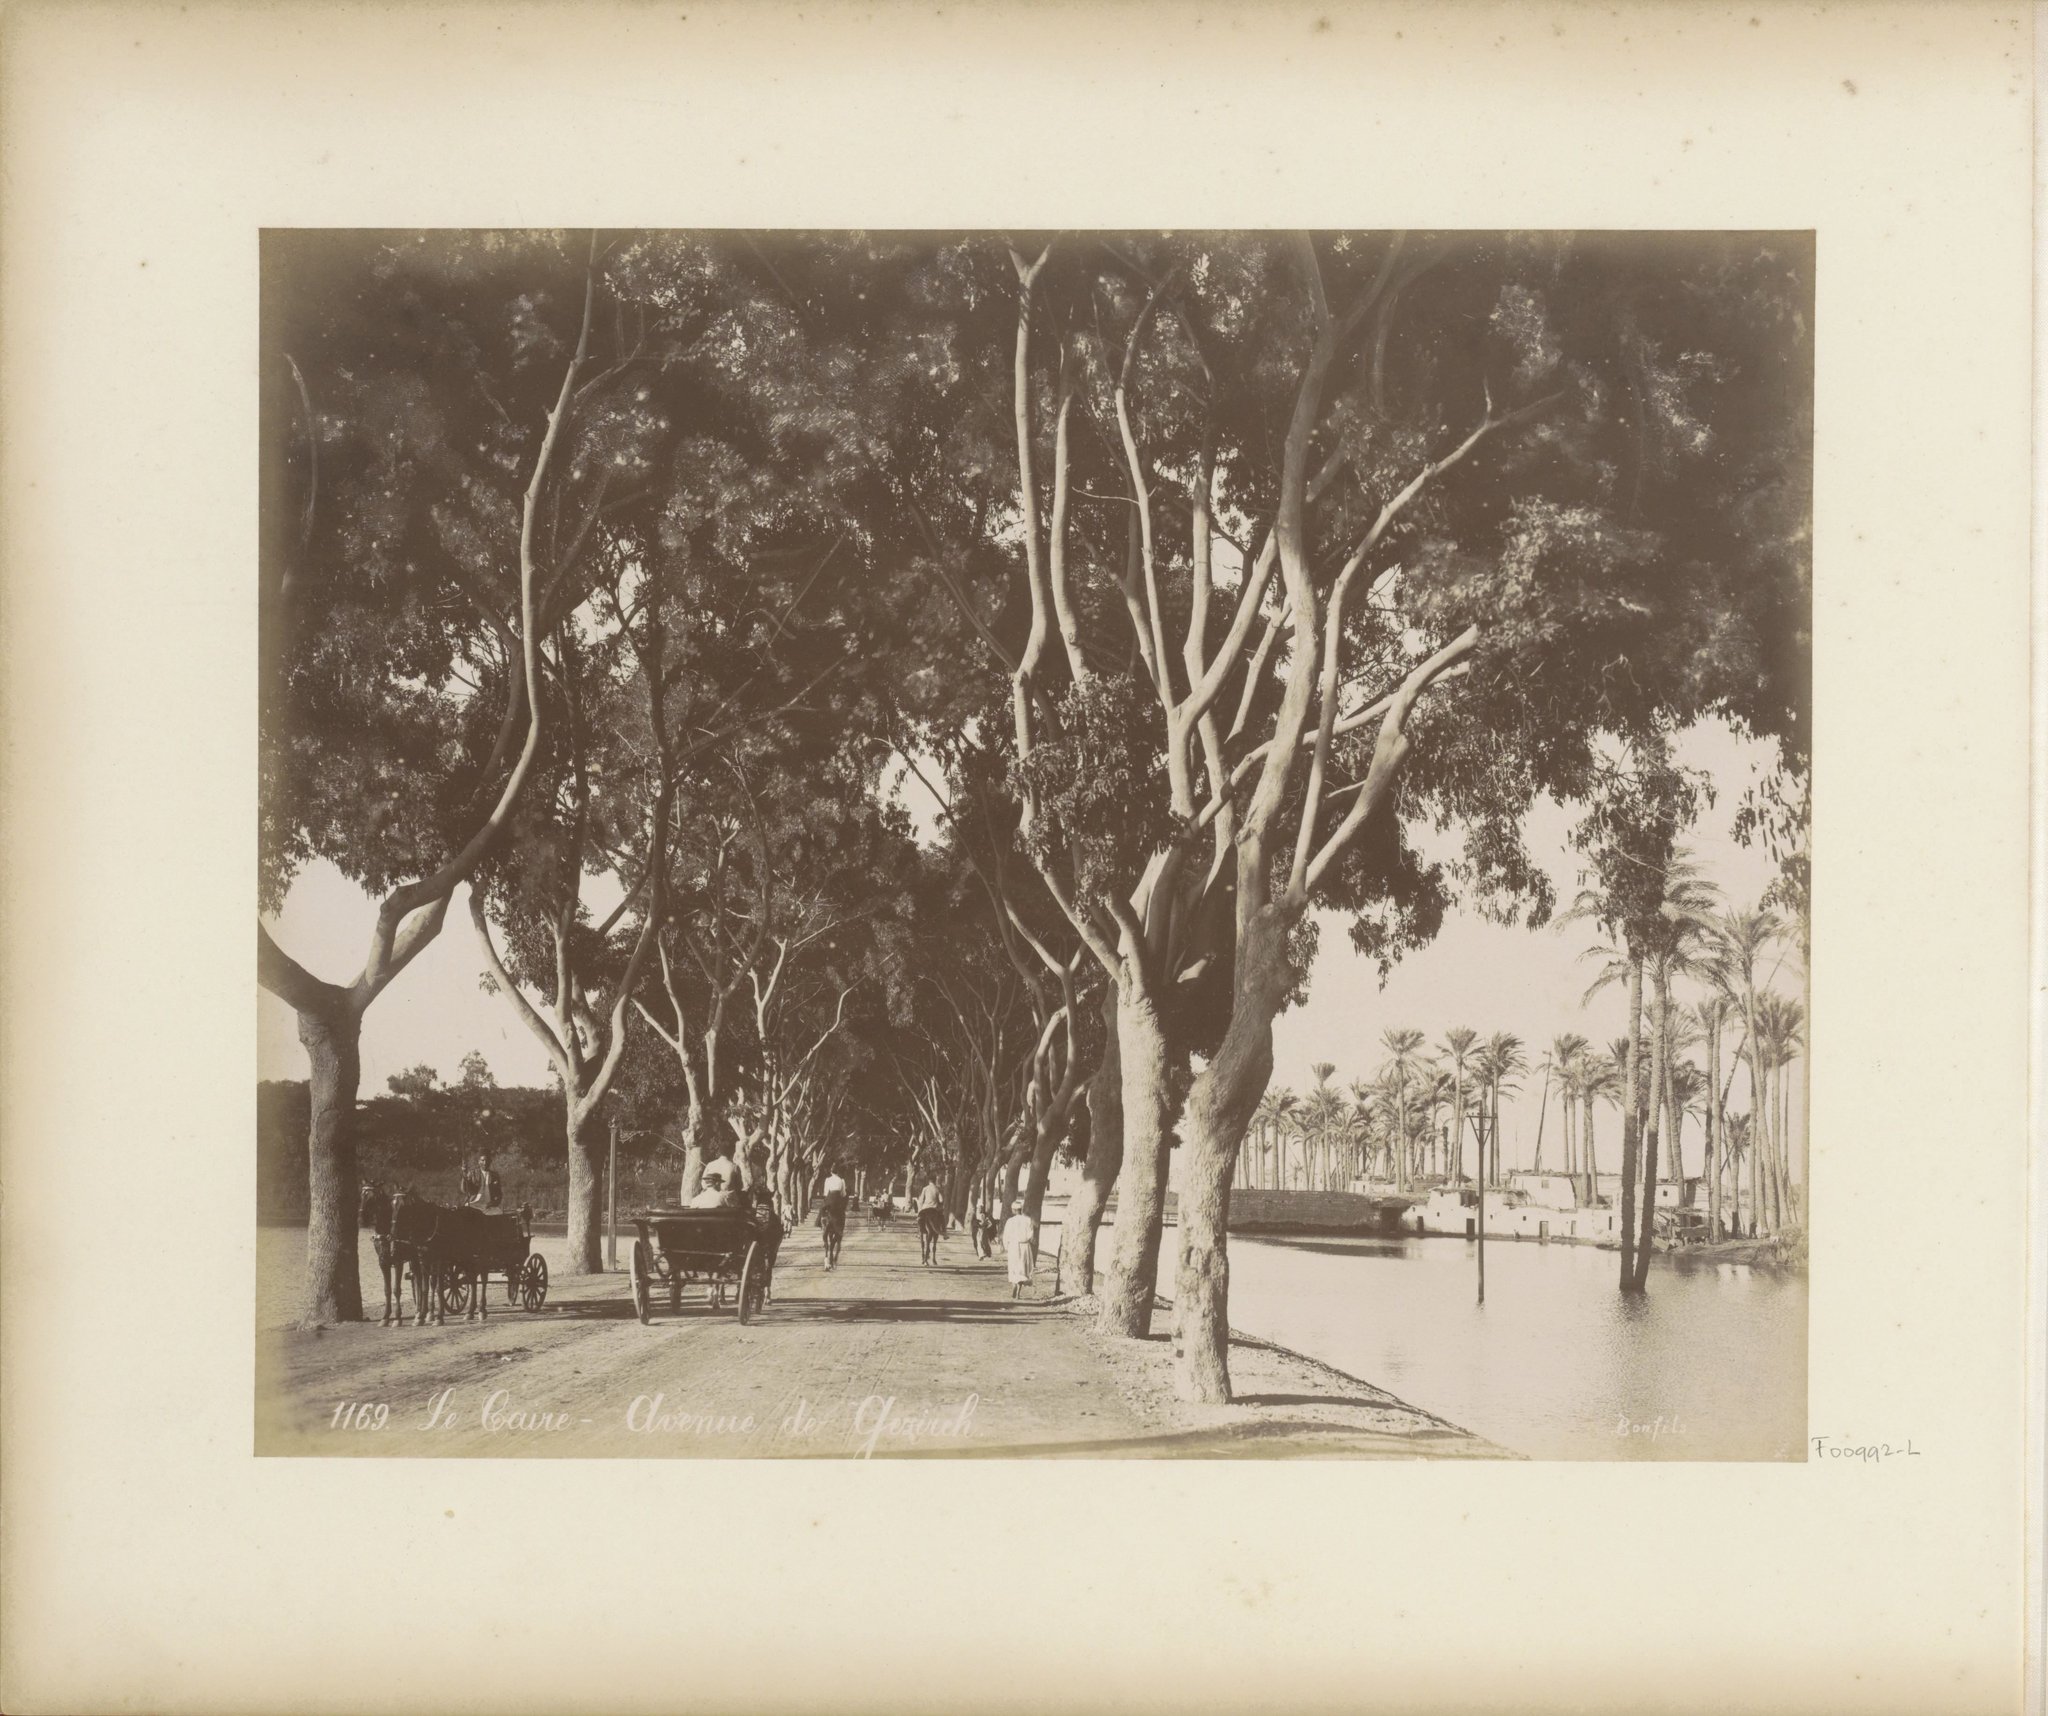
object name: photograph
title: Paarden en wagens op de Avenue de Gezireh in Caïro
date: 1870-1898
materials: cardboard, paper, photographic support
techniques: albumen print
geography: cairo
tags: avenue, boulevard, promenade, esplanade (+ city(-scape) with figures, staffage)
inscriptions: negative number: ‘1169’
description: Onderdeel van Reisalbum met 80 foto's van Egypte.